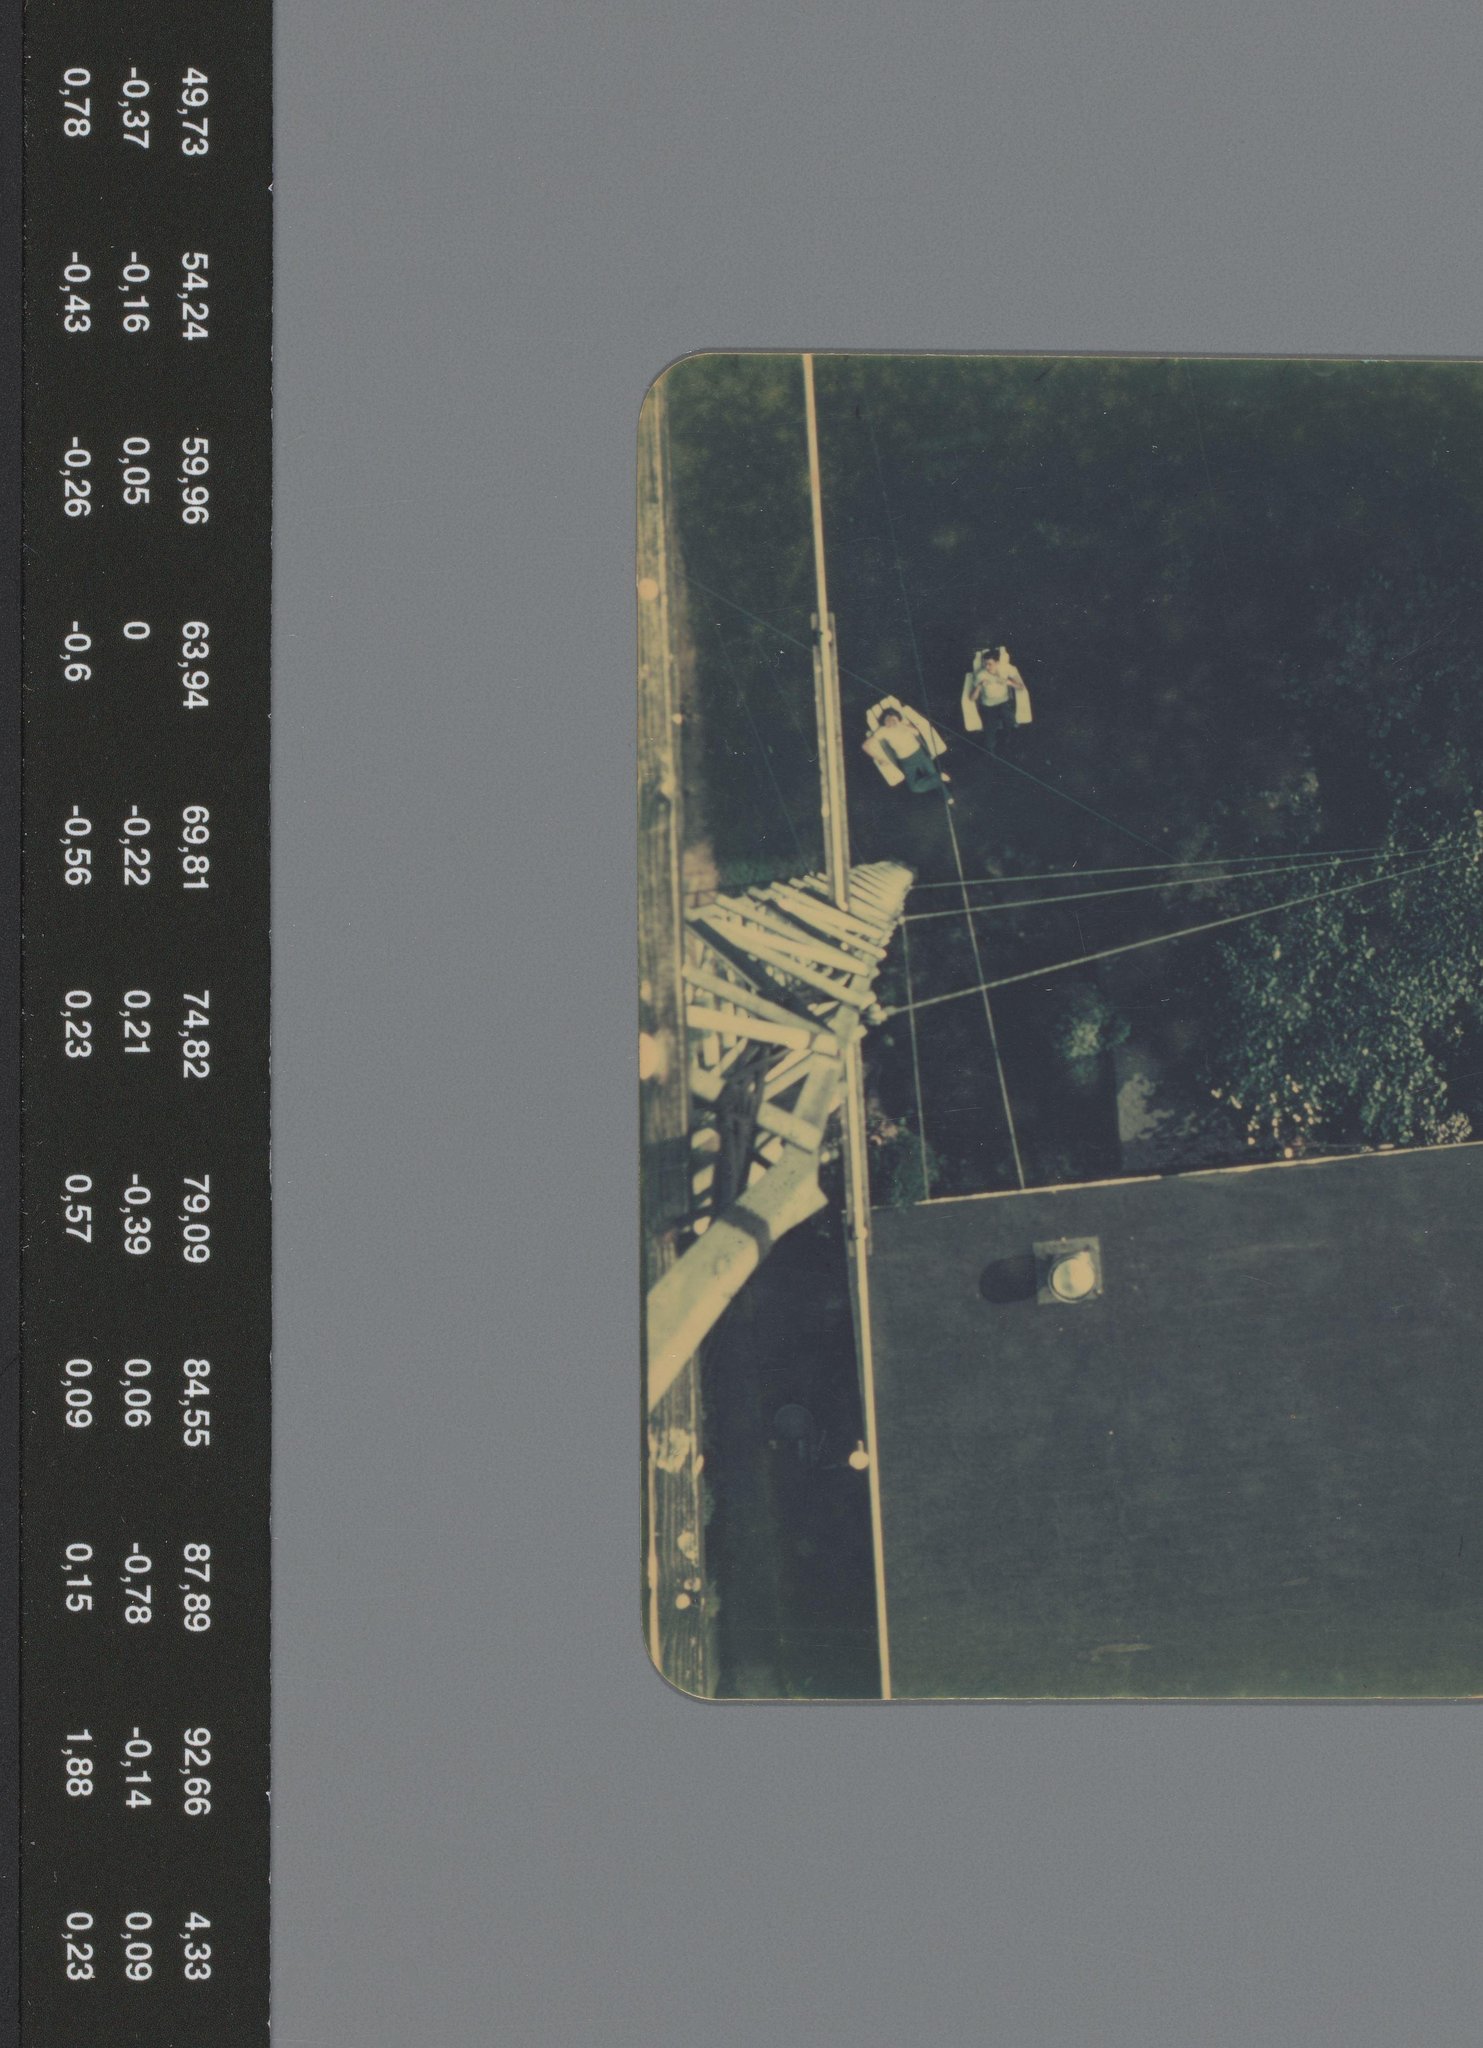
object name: photograph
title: Snapshot van bovenaf: op de manier van 'The Powers of Ten'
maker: Anonymous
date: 1948-1955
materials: photographic support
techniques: chromogenic print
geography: united states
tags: united states of america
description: Opname vanuit een mast recht naar beneden. In de hoek van een tuin op het gras zitten twee mensen in tuinstoelen.